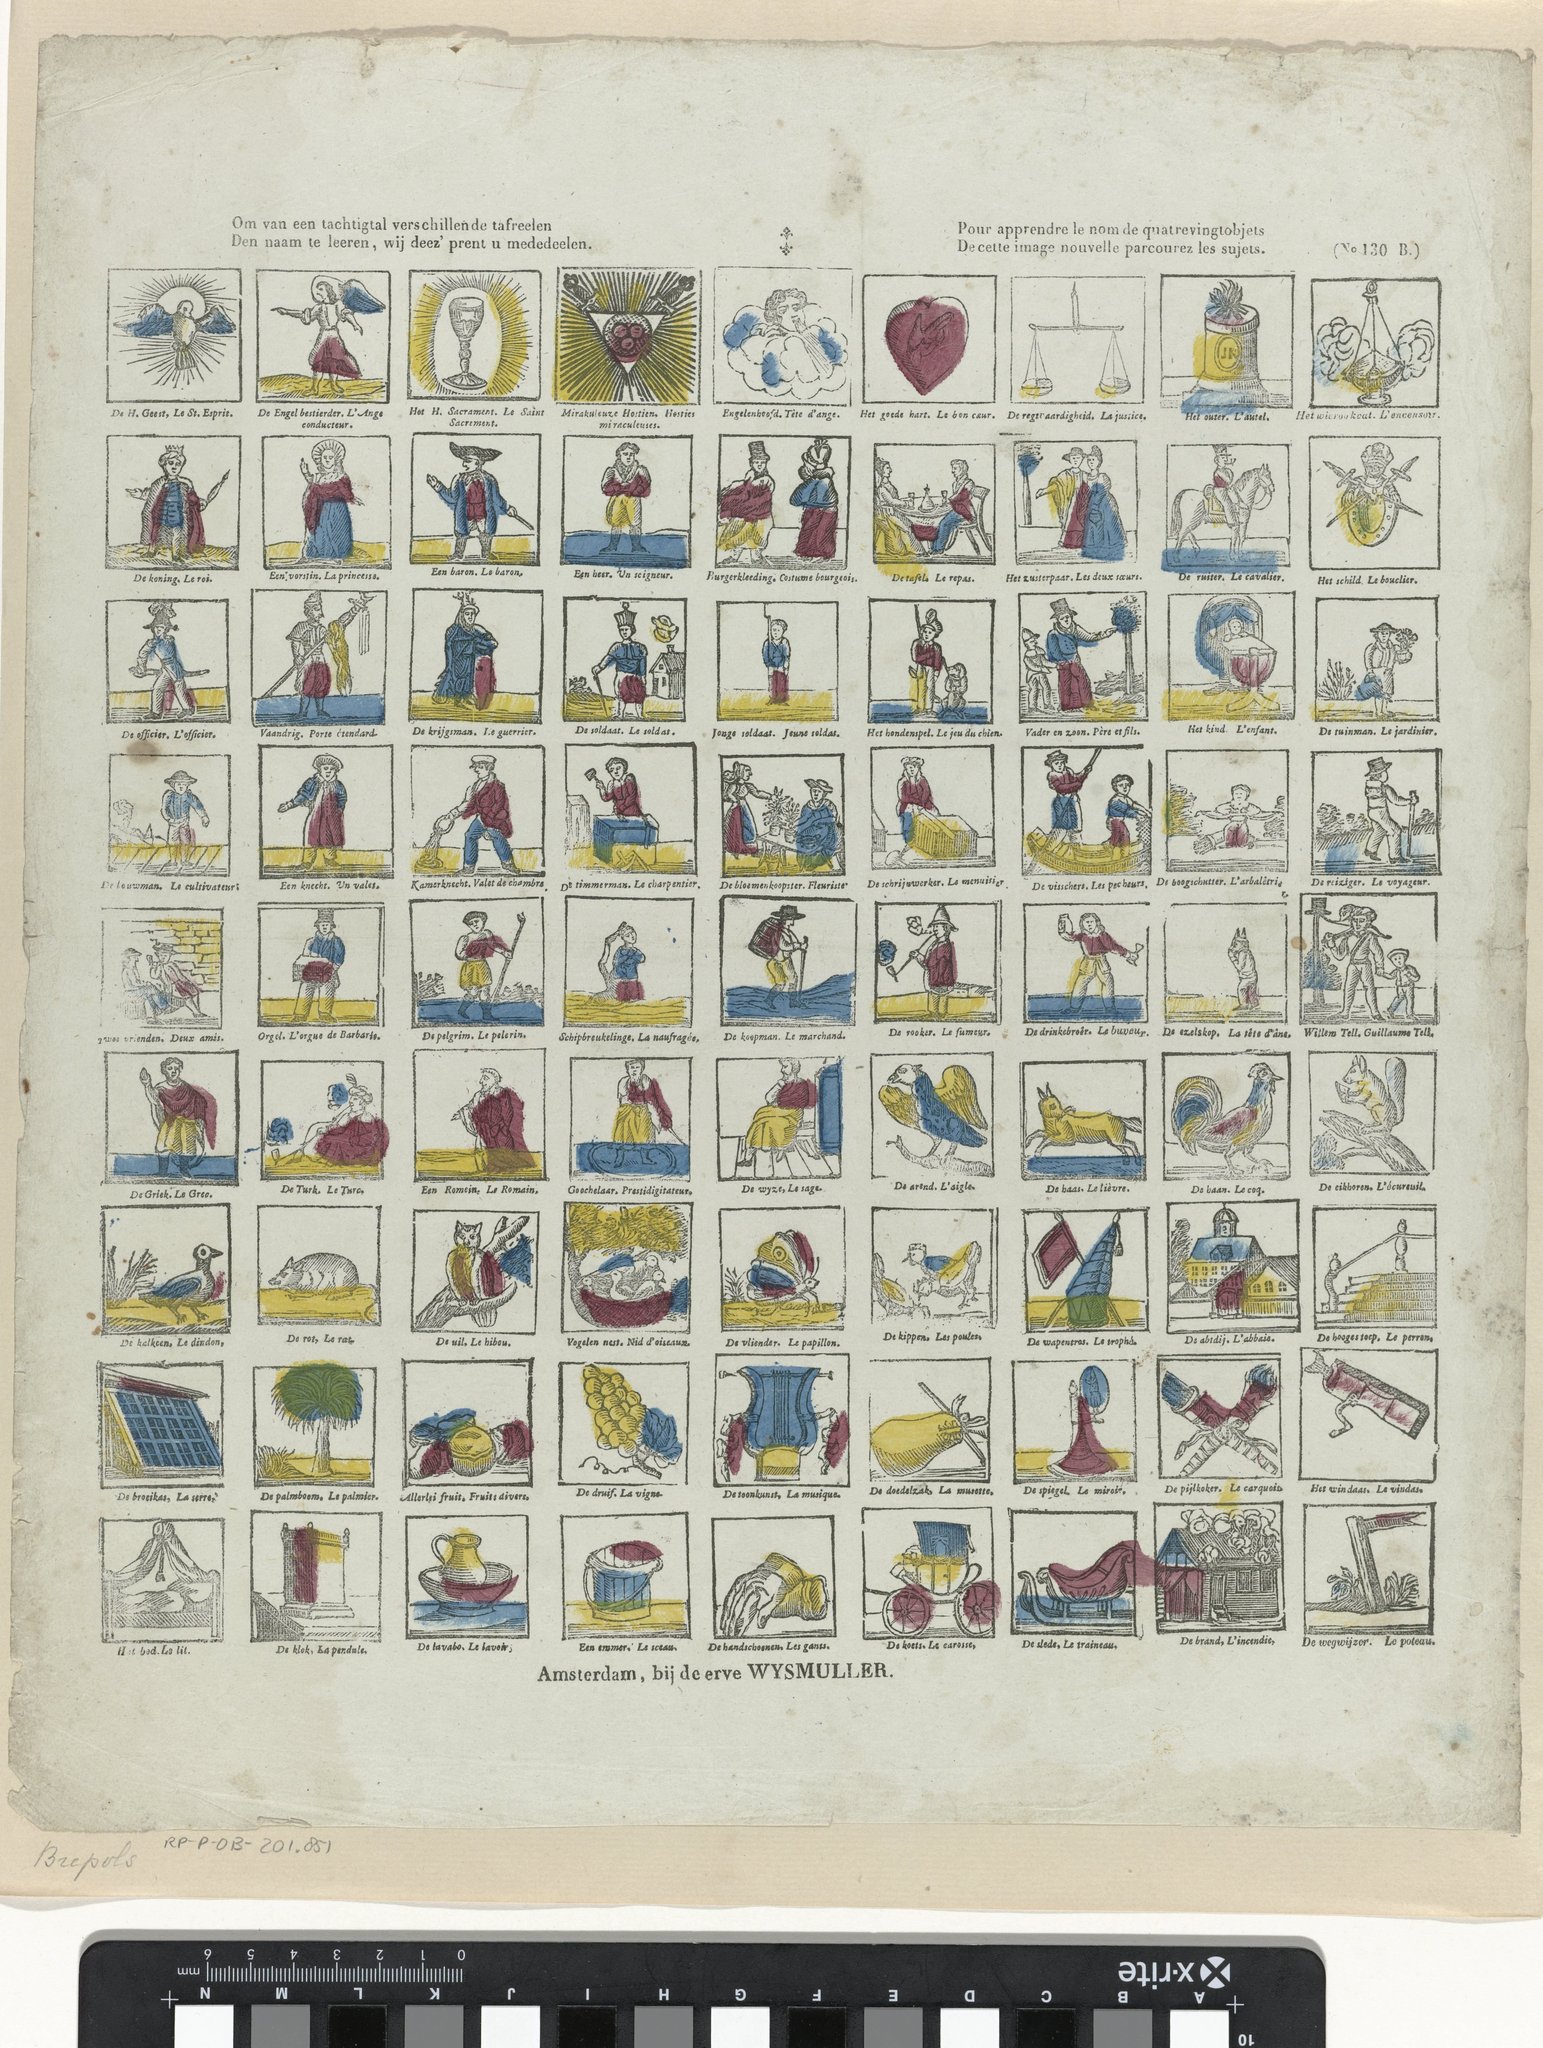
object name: popular print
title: Om van een tachtigtal verschillende tafreelen / Den naam te leeren, wij deez' prent u mededeelen / Pour apprendre le nom de quatrevingtobjets / De cette image nouvelle parcourez les sujets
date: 1828-1913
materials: paper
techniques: colour, letterpress printing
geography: turnhout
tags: animals, characters (human types)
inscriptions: collector's mark: Lugt 2760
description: Blad met 81 voorstellingen van verschillende voorwerpen, dieren en figuren. Onder elke afbeelding een onderschrift in het Nederlands en in het Frans. Genummerd rechtsboven: (No. 130 B).